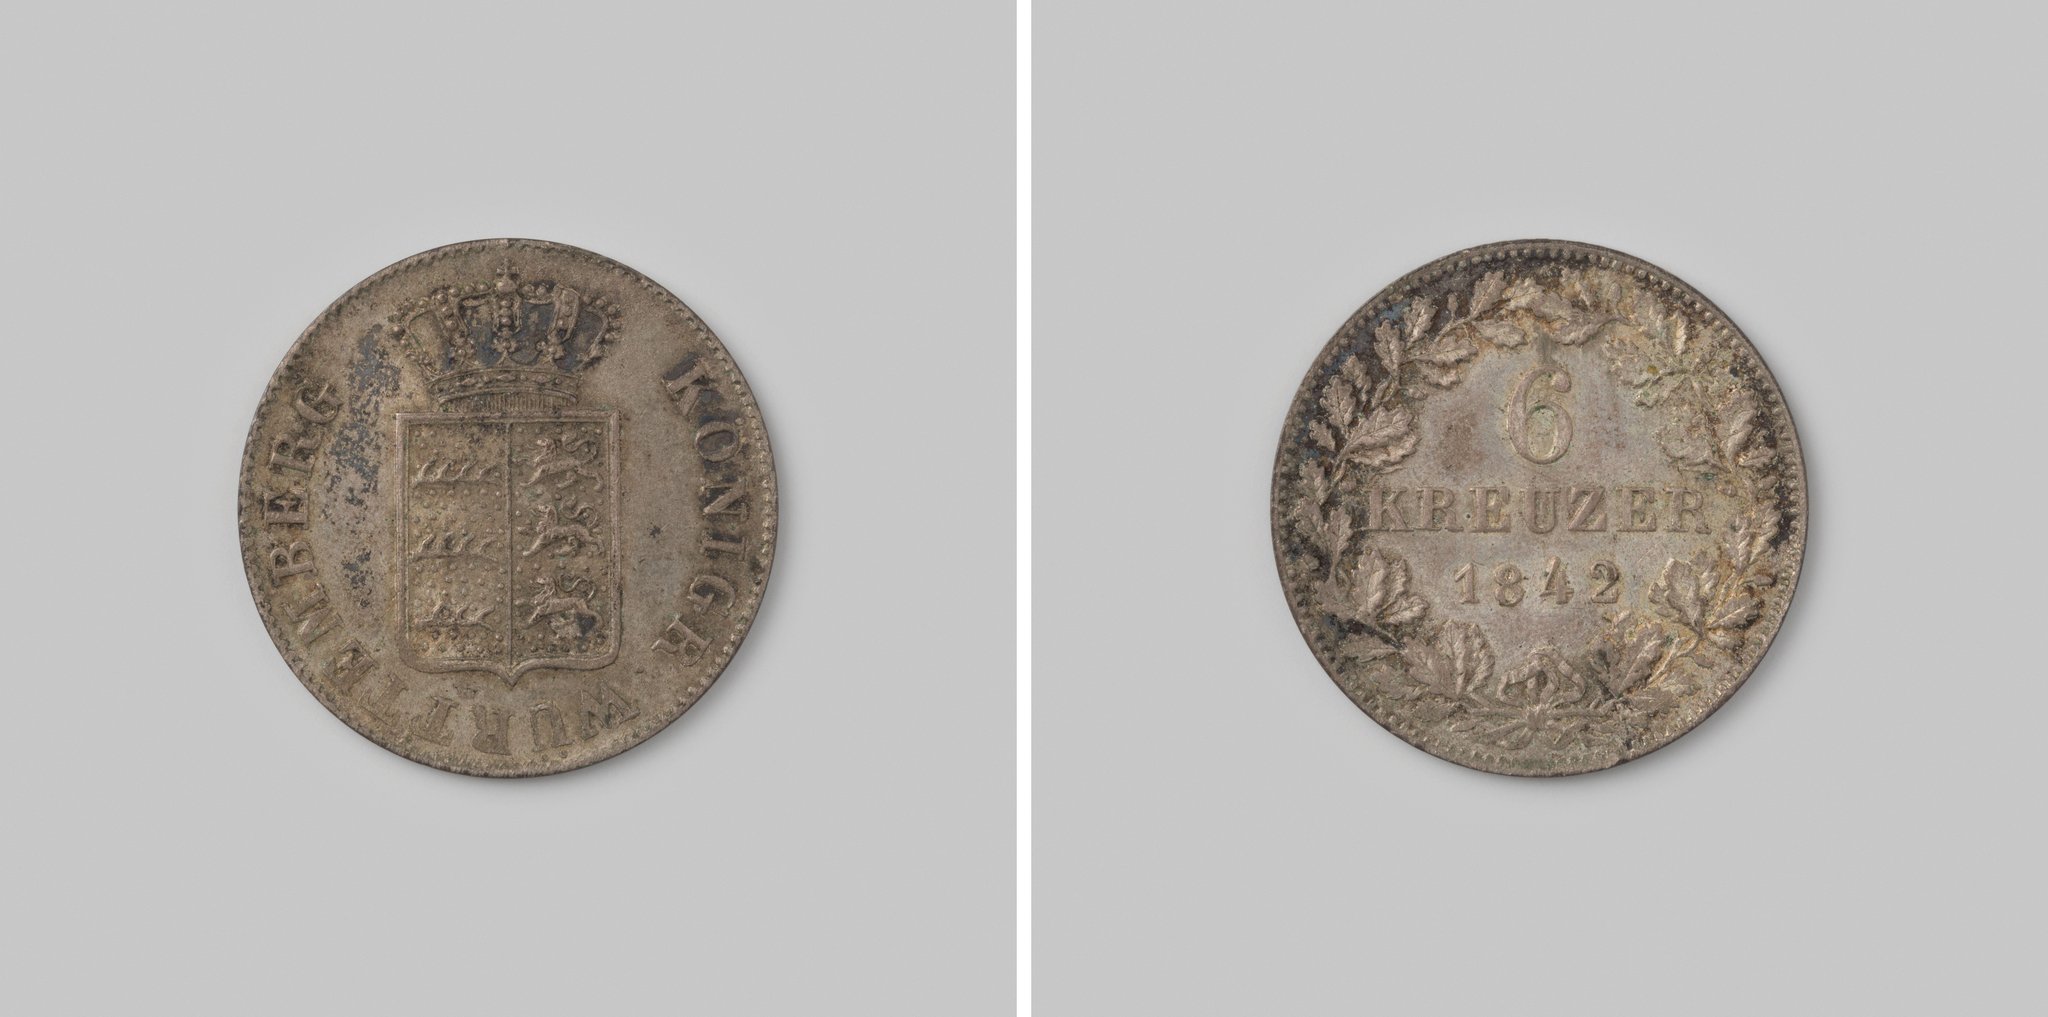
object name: coin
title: Wurtemberg, Wilhelm I, 6 kreuzer, 1842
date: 1842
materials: silver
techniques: striking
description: Zilveren munt. Voorzijde: gekroond samengesteld wapenschild. Keerzijde: binnen twee samengebonden eiketakken waarde-aanduiding in twee regels, waaronder jaartal. Kartelrand.